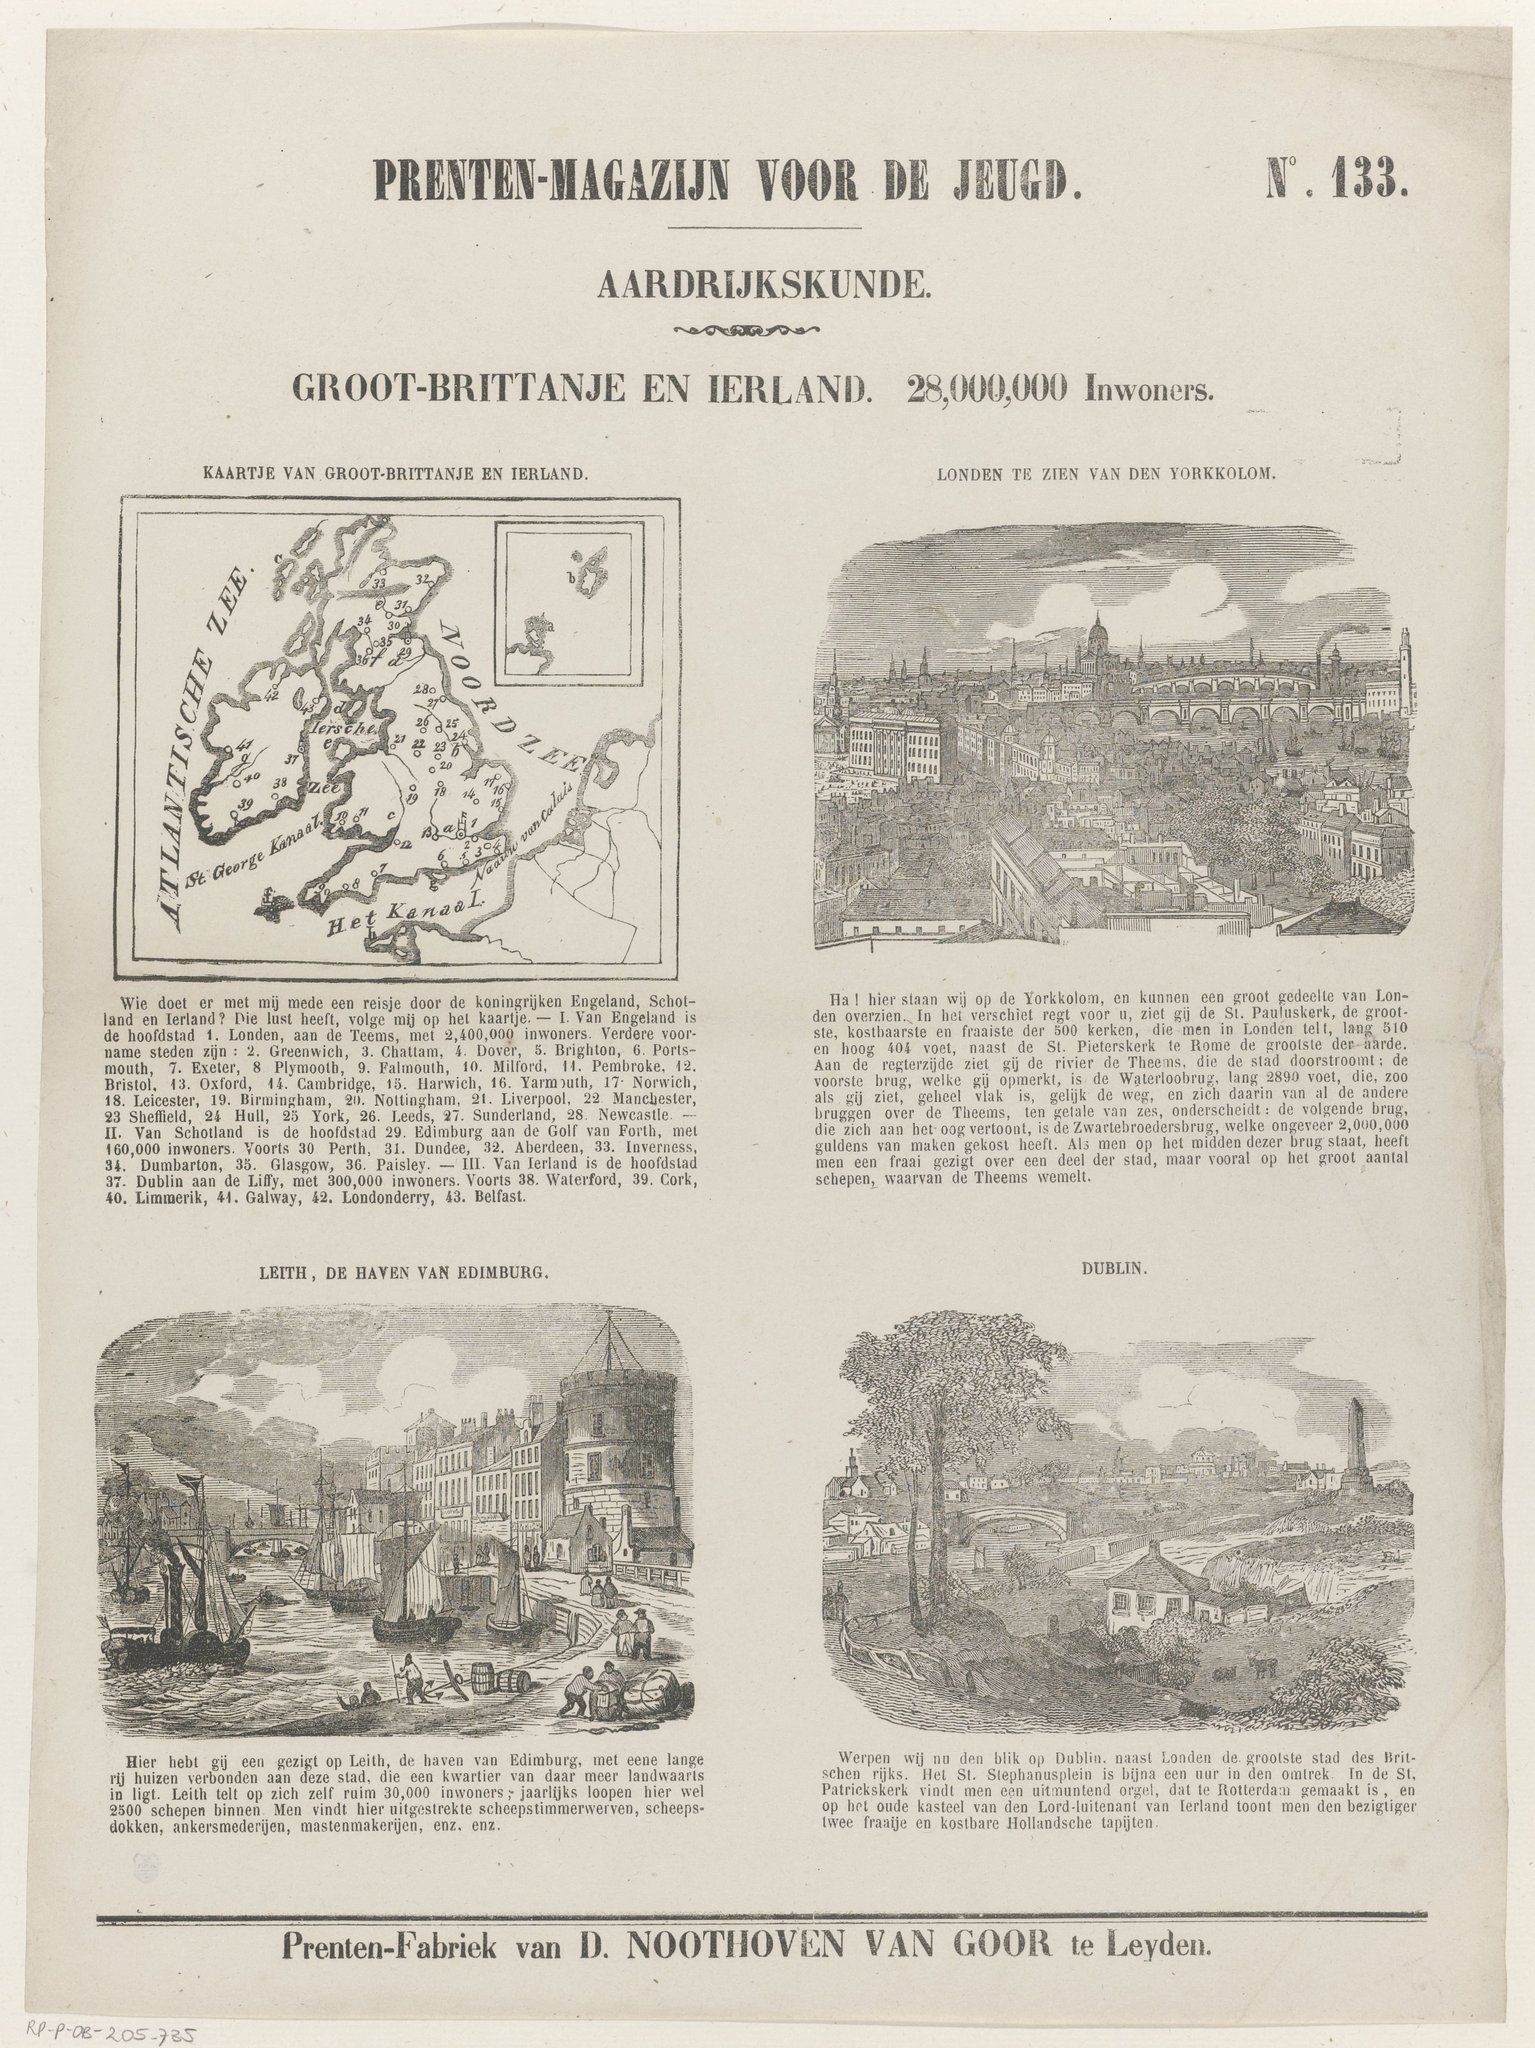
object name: popular print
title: Prenten-magazijn voor de jeugd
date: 1850-1881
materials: paper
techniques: letterpress printing, engraving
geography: netherlands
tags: maps, atlases, great britain, london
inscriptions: collector's mark: Lugt 2760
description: Blad met 4 voorstellingen over Groot-Brittannië en Ierland met een kaart en belangrijke steden: Londen, Edinburgh en Dublin. Boven elke voorstelling een titel en onder elke voorstelling een onderschrift. Genummerd rechtsboven: No. 133.